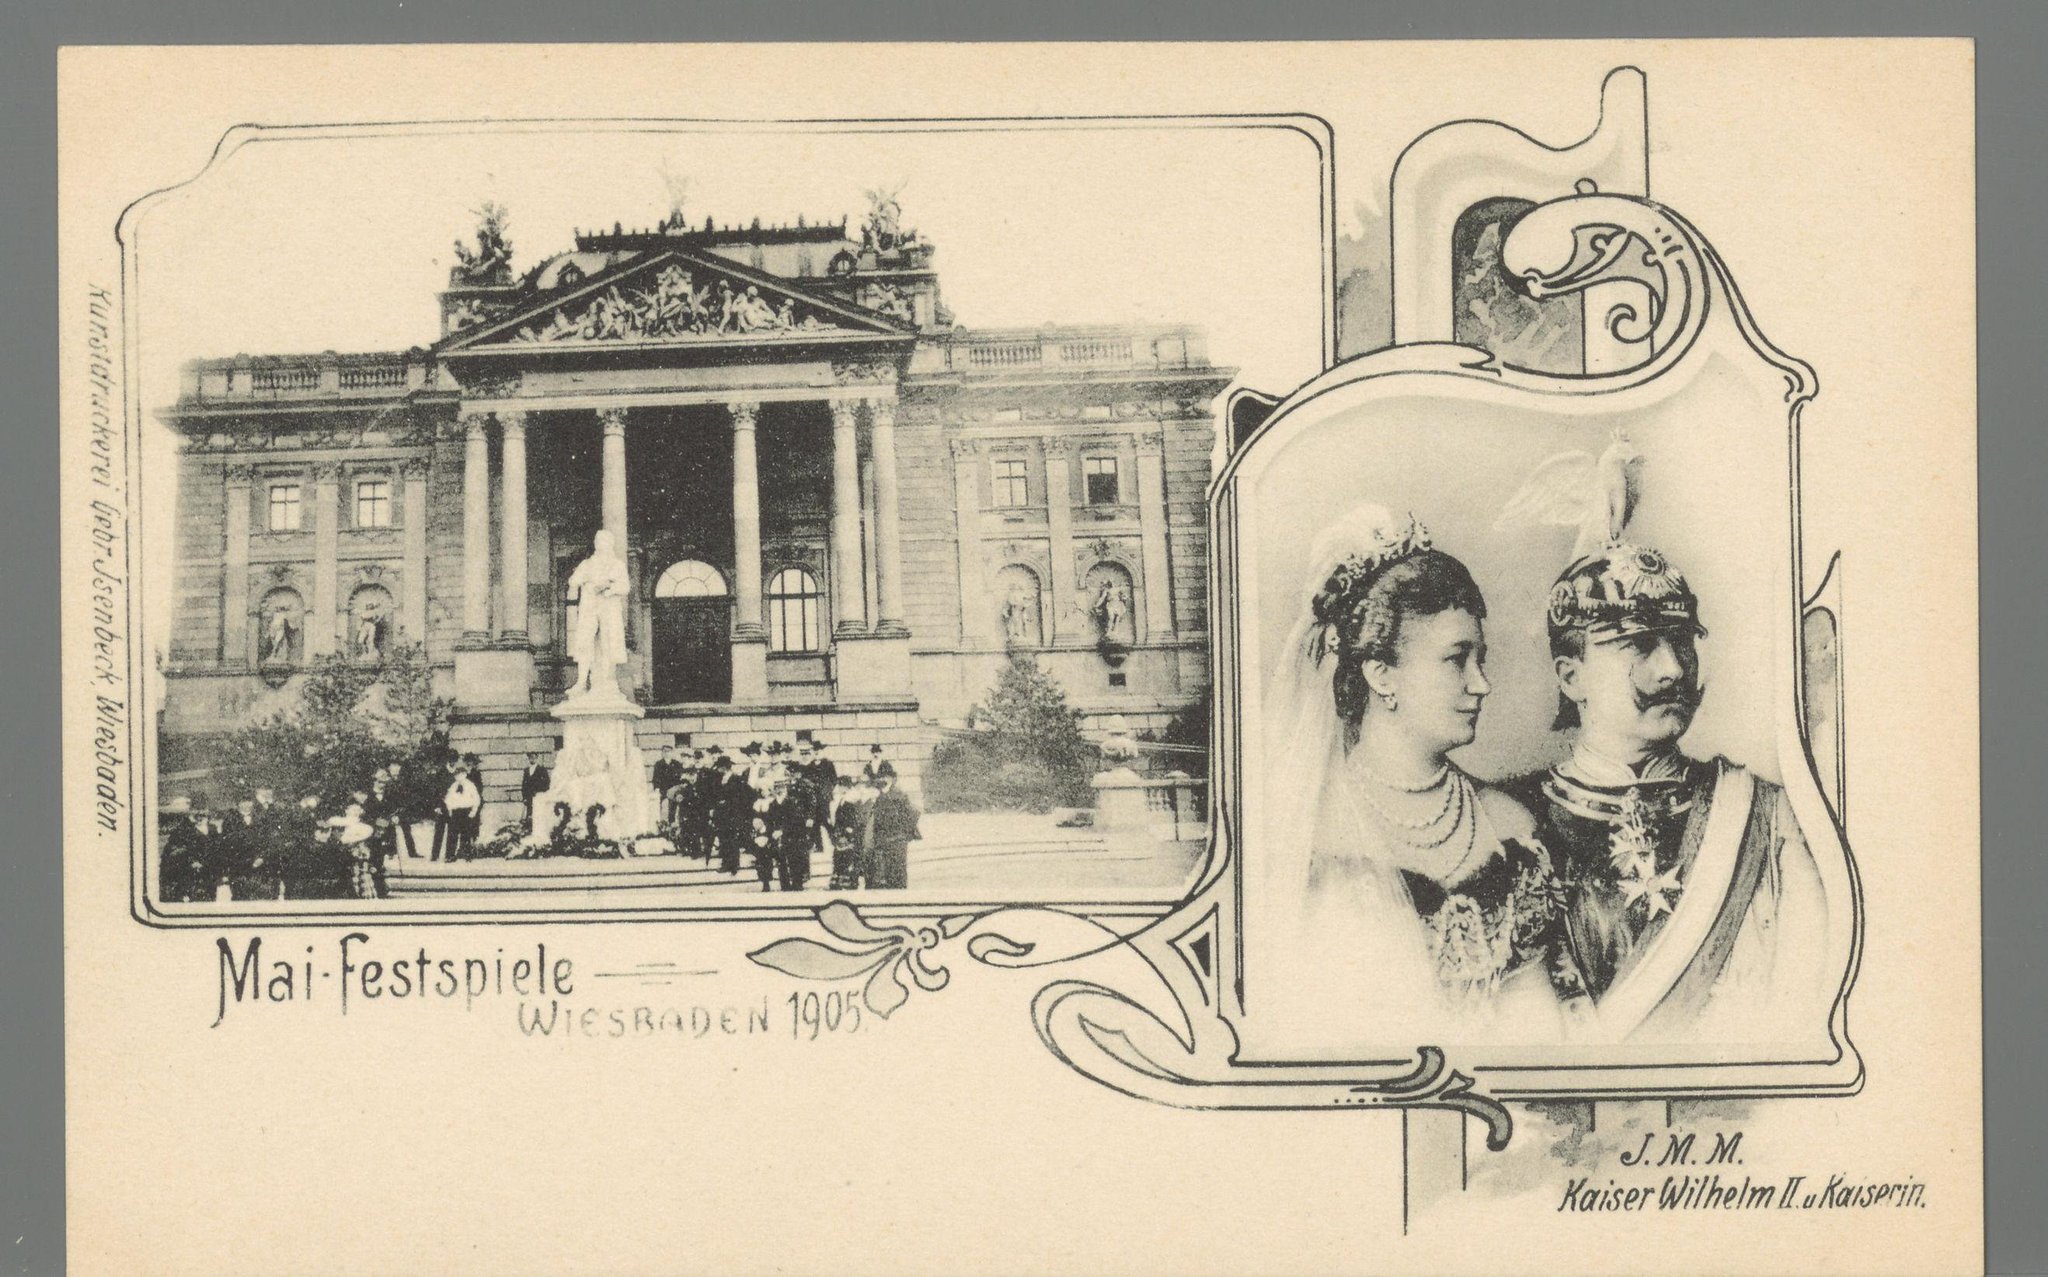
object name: photomechanical print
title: Mai-festspiele. Wiesbaden 1905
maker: Anonymous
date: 1905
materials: cardboard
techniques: photograph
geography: wiesbaden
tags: wilhelm ii (keizer van duitsland), augusta victoria (keizerin van duitsland), queen, empress, etc. (wife of a ruler), theatre (building), emperor, monument, statue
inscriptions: date